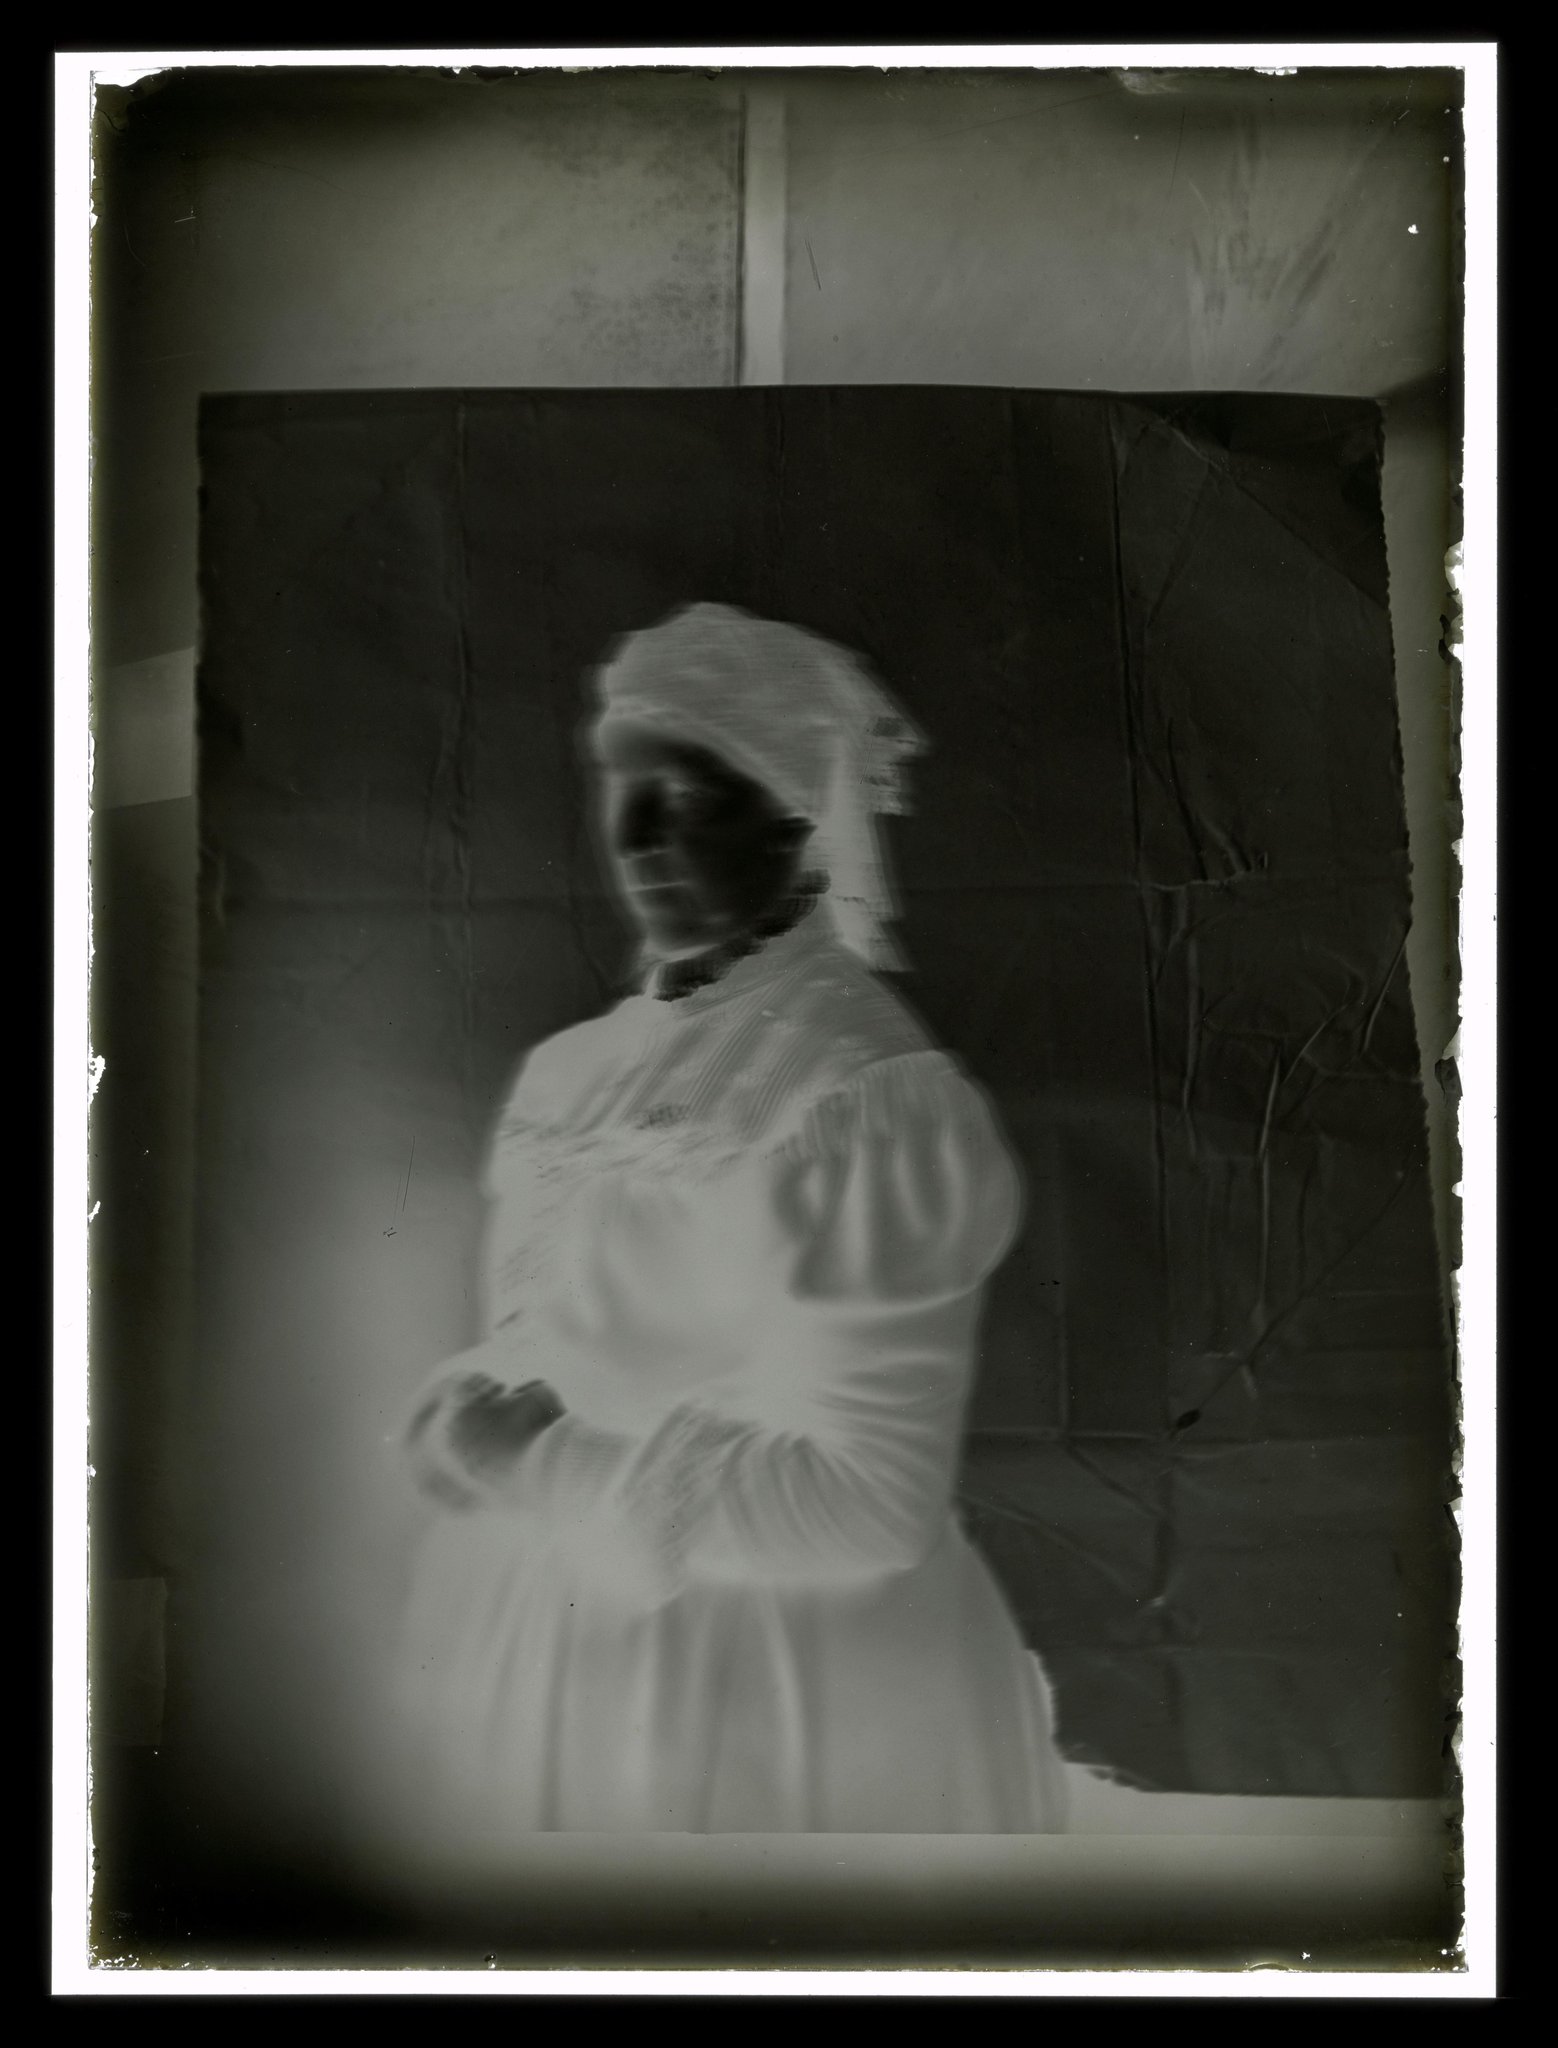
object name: glasnegatief, glasplaatnegatief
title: Portret van een onbekende vrouw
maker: laurens lodewijk kleijn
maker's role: draughtsman, painter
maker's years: 1826-1909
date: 1865-1900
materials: glass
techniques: collodion process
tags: anonymous historical person portrayed - bb - woman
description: Onderdeel van een groep glasnegatieven uit de nalatenschap van de schilder Laurens Lodewijk Kleijn, met stillevens, portretten, zelfportretten en kunstreproducties.